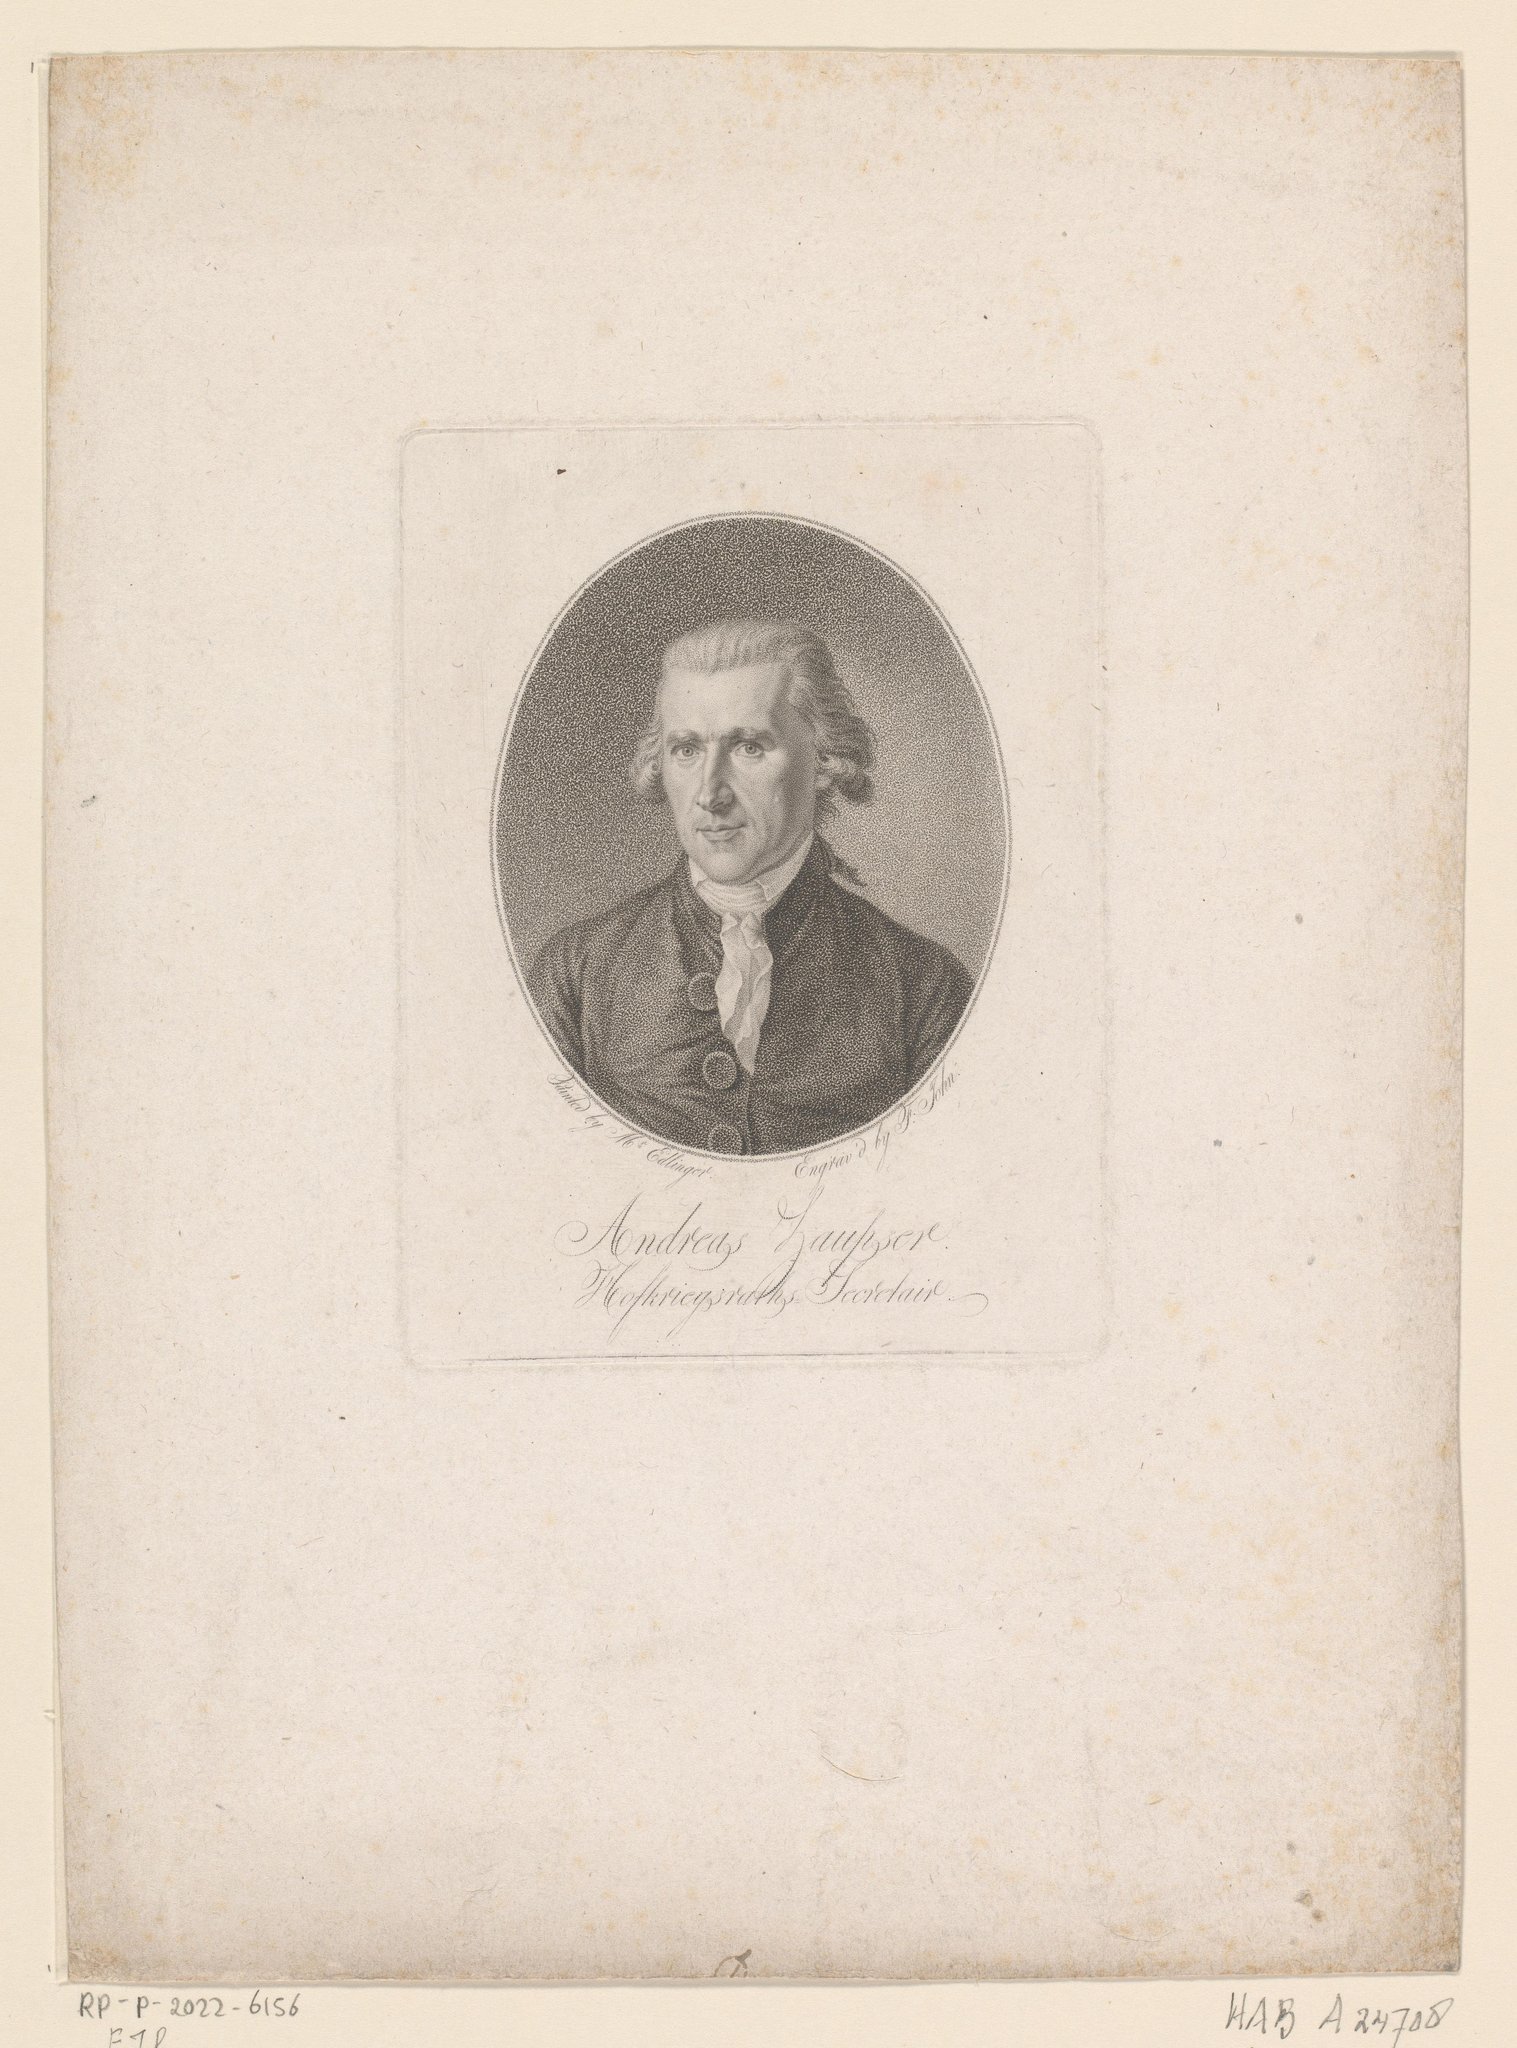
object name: print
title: Portret van Andreas Zaupser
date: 1789-1795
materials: paper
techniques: stippling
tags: publisher, historical persons, lawyer, attorney at law, scholar, philosopher (+ portrait of scholar, scientist)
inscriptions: number: ‘81.’